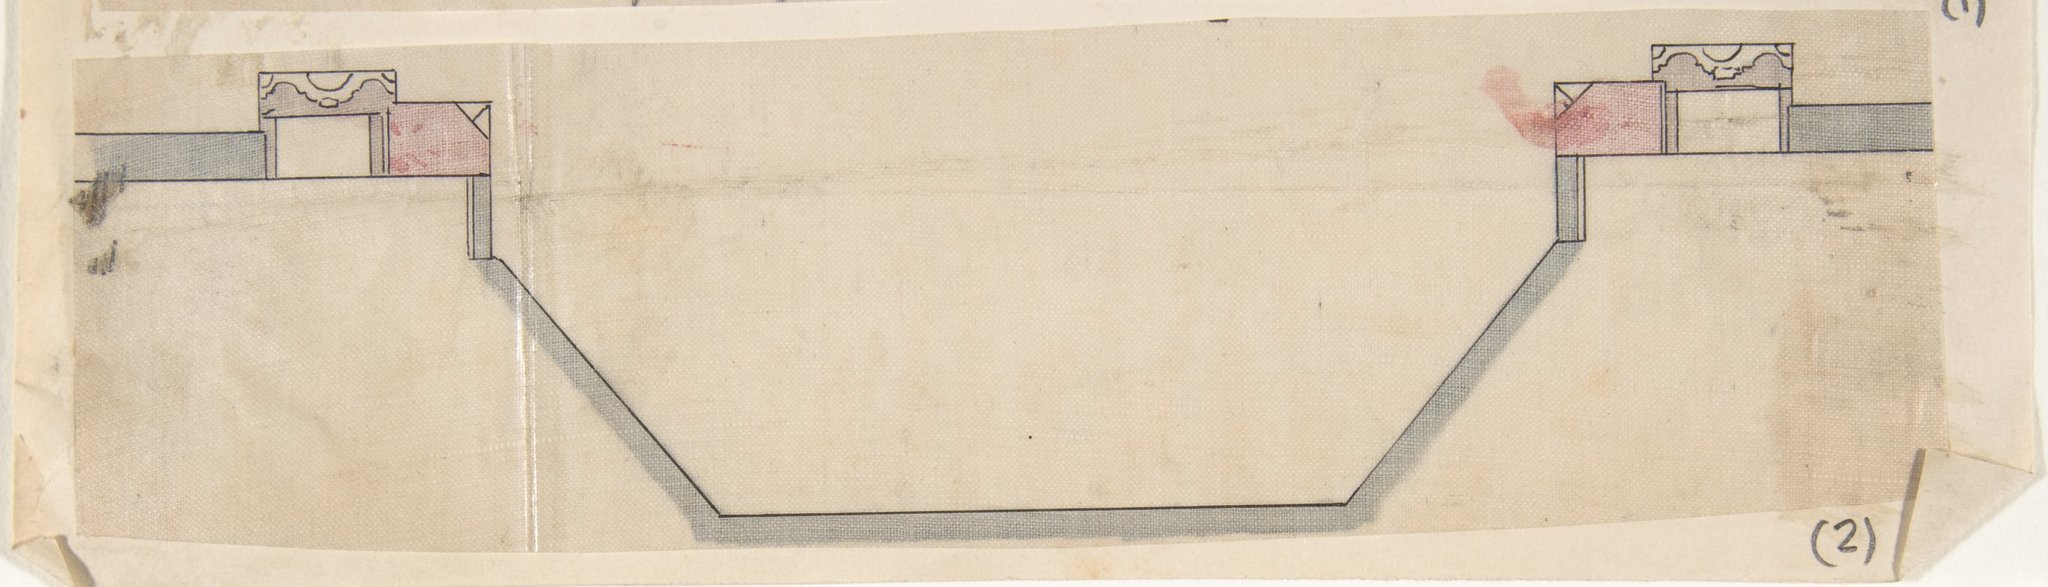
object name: drawing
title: Design for Fireplace and Grate: Plan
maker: anonymous, british, 19th century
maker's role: artist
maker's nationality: british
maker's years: 1800-1900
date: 1801-1900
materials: ink, linen, watercolor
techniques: pen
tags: fireplaces